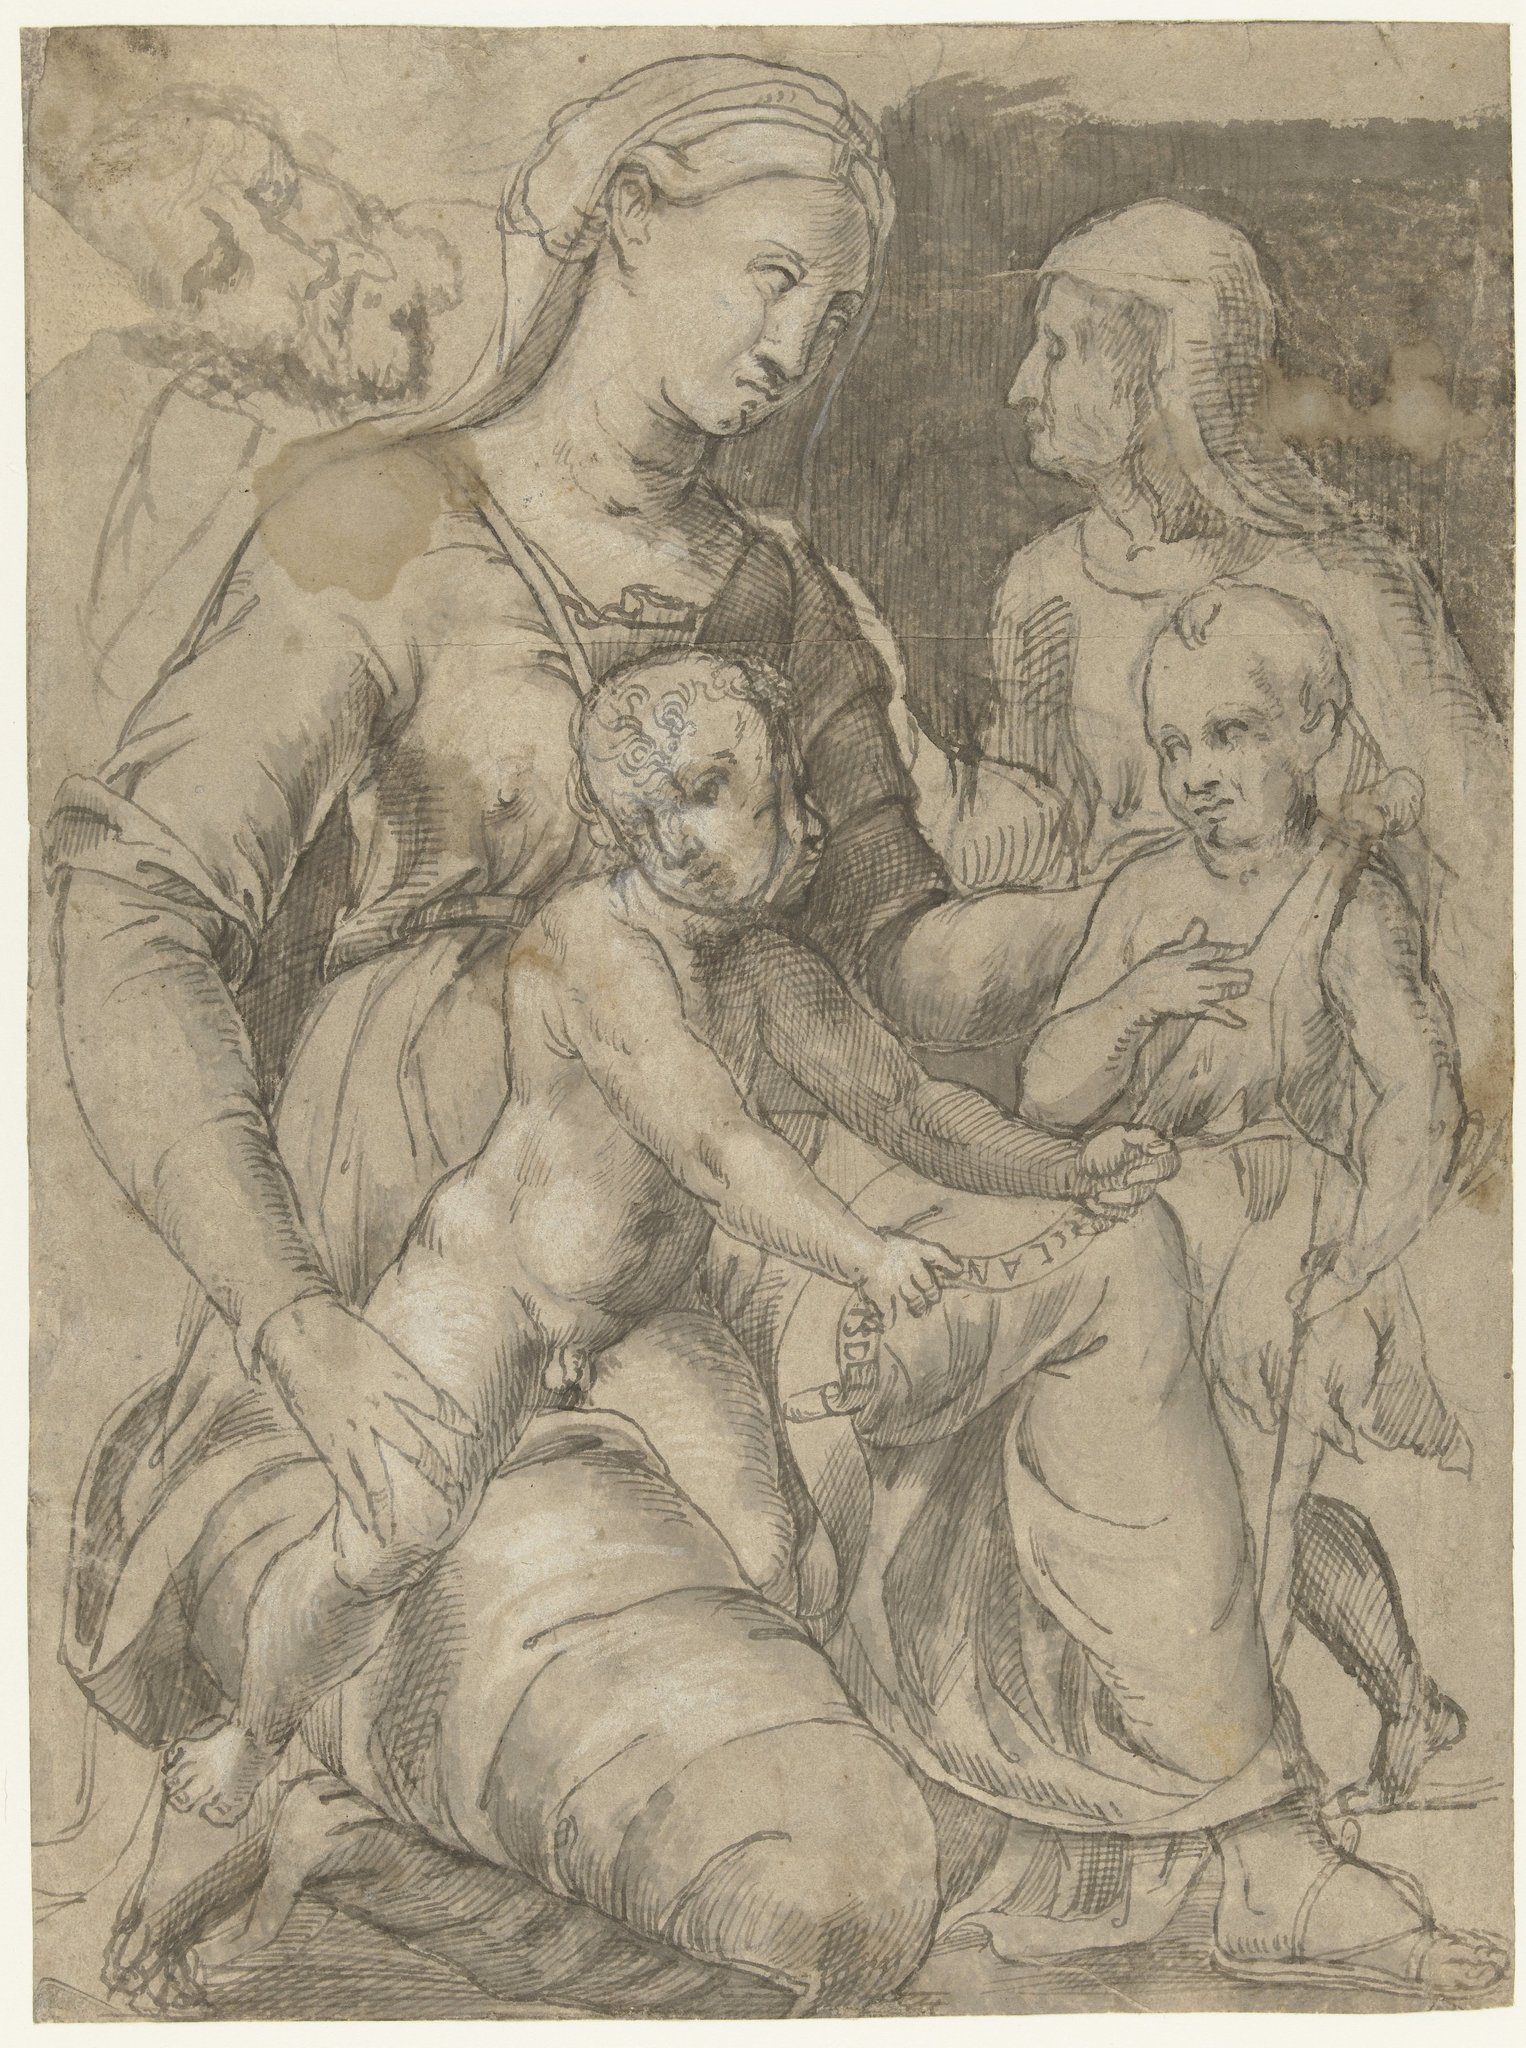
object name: drawing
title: Heilige familie met Johannes de Doper en Elizabeth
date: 1540-1560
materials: chalk, ink, paper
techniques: brush, pen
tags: holy family with john the baptist (as child)